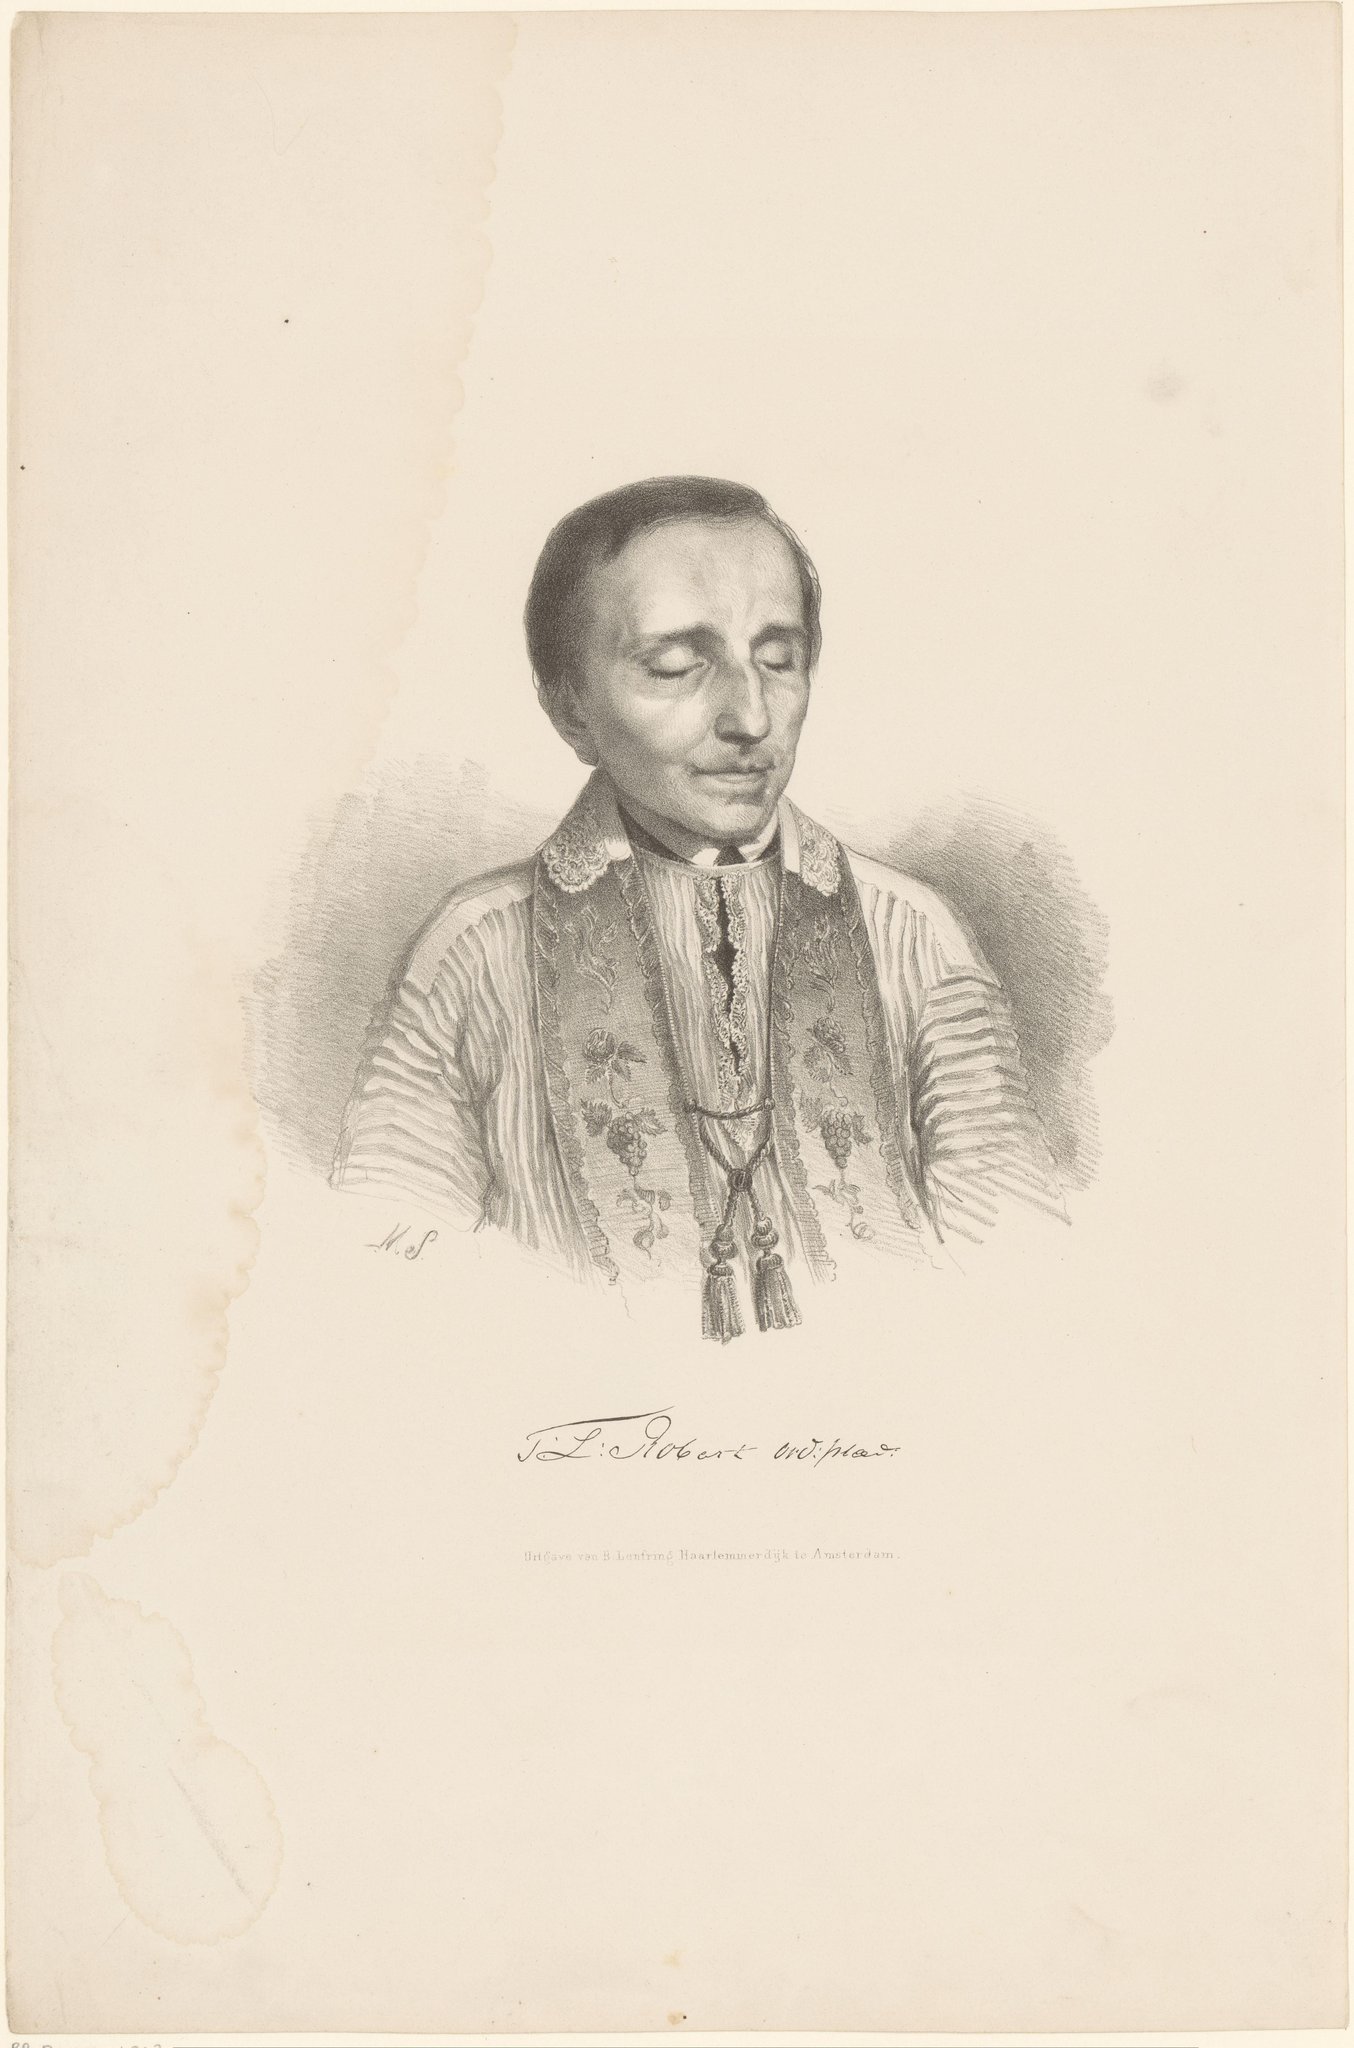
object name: print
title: Portret van een blinde geestelijke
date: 1855-1904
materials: paper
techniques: lithograph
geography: amsterdam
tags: eyes closed, historical persons (+ (full) bust portrait)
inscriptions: collector's mark: Lugt 2228, monogram: ‘MS’